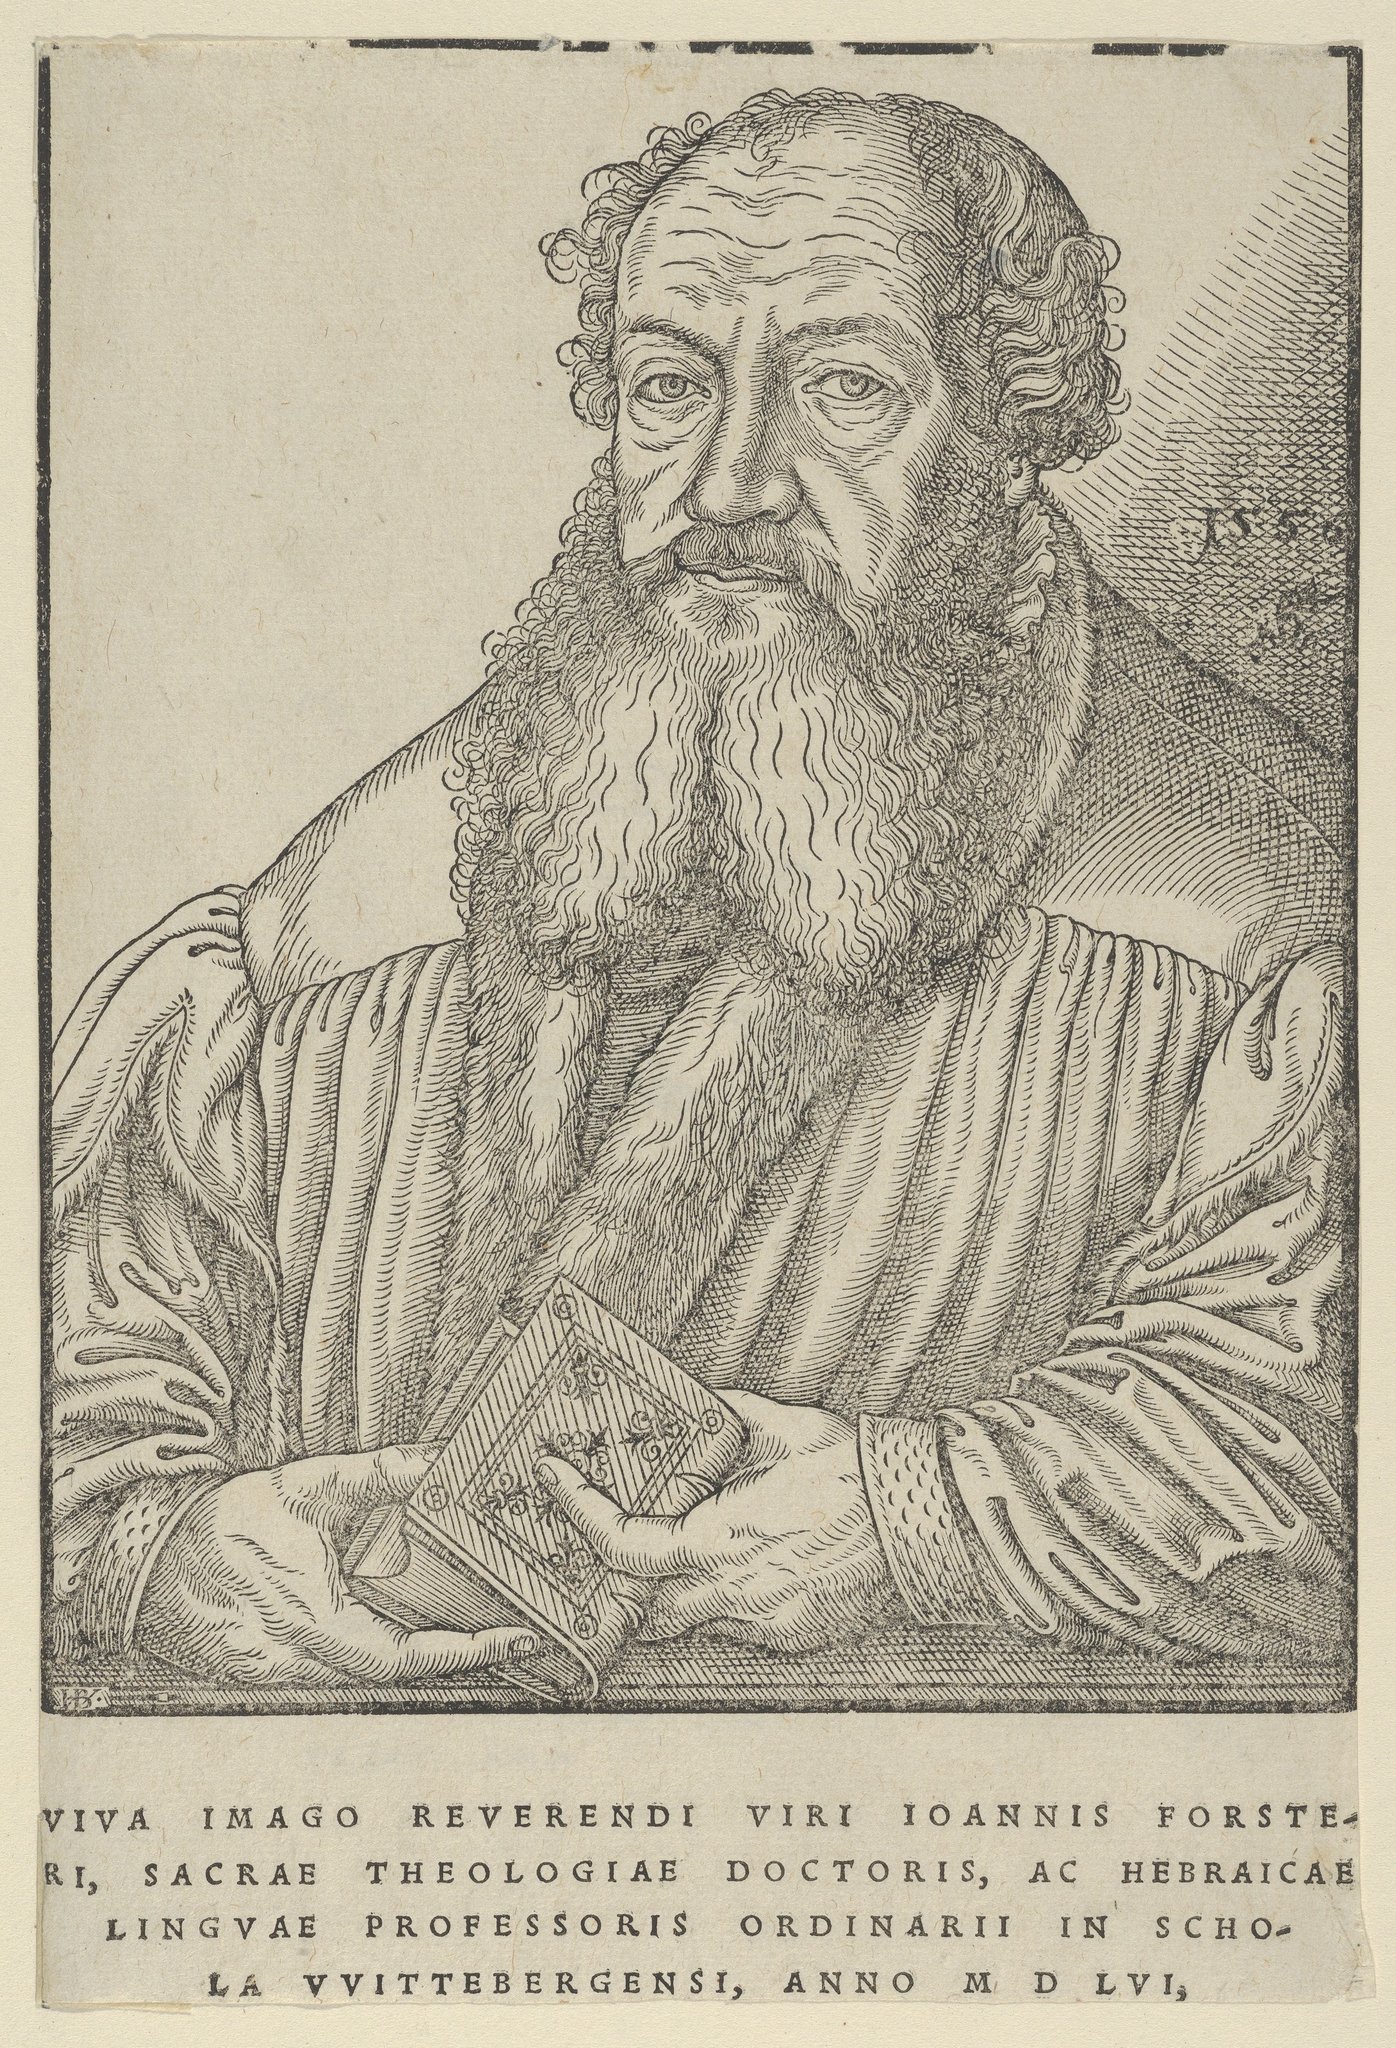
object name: print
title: Johann Forster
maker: lucas cranach the younger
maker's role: artist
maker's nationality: german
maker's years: 1515-1586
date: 1556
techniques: woodcut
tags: men,portraits